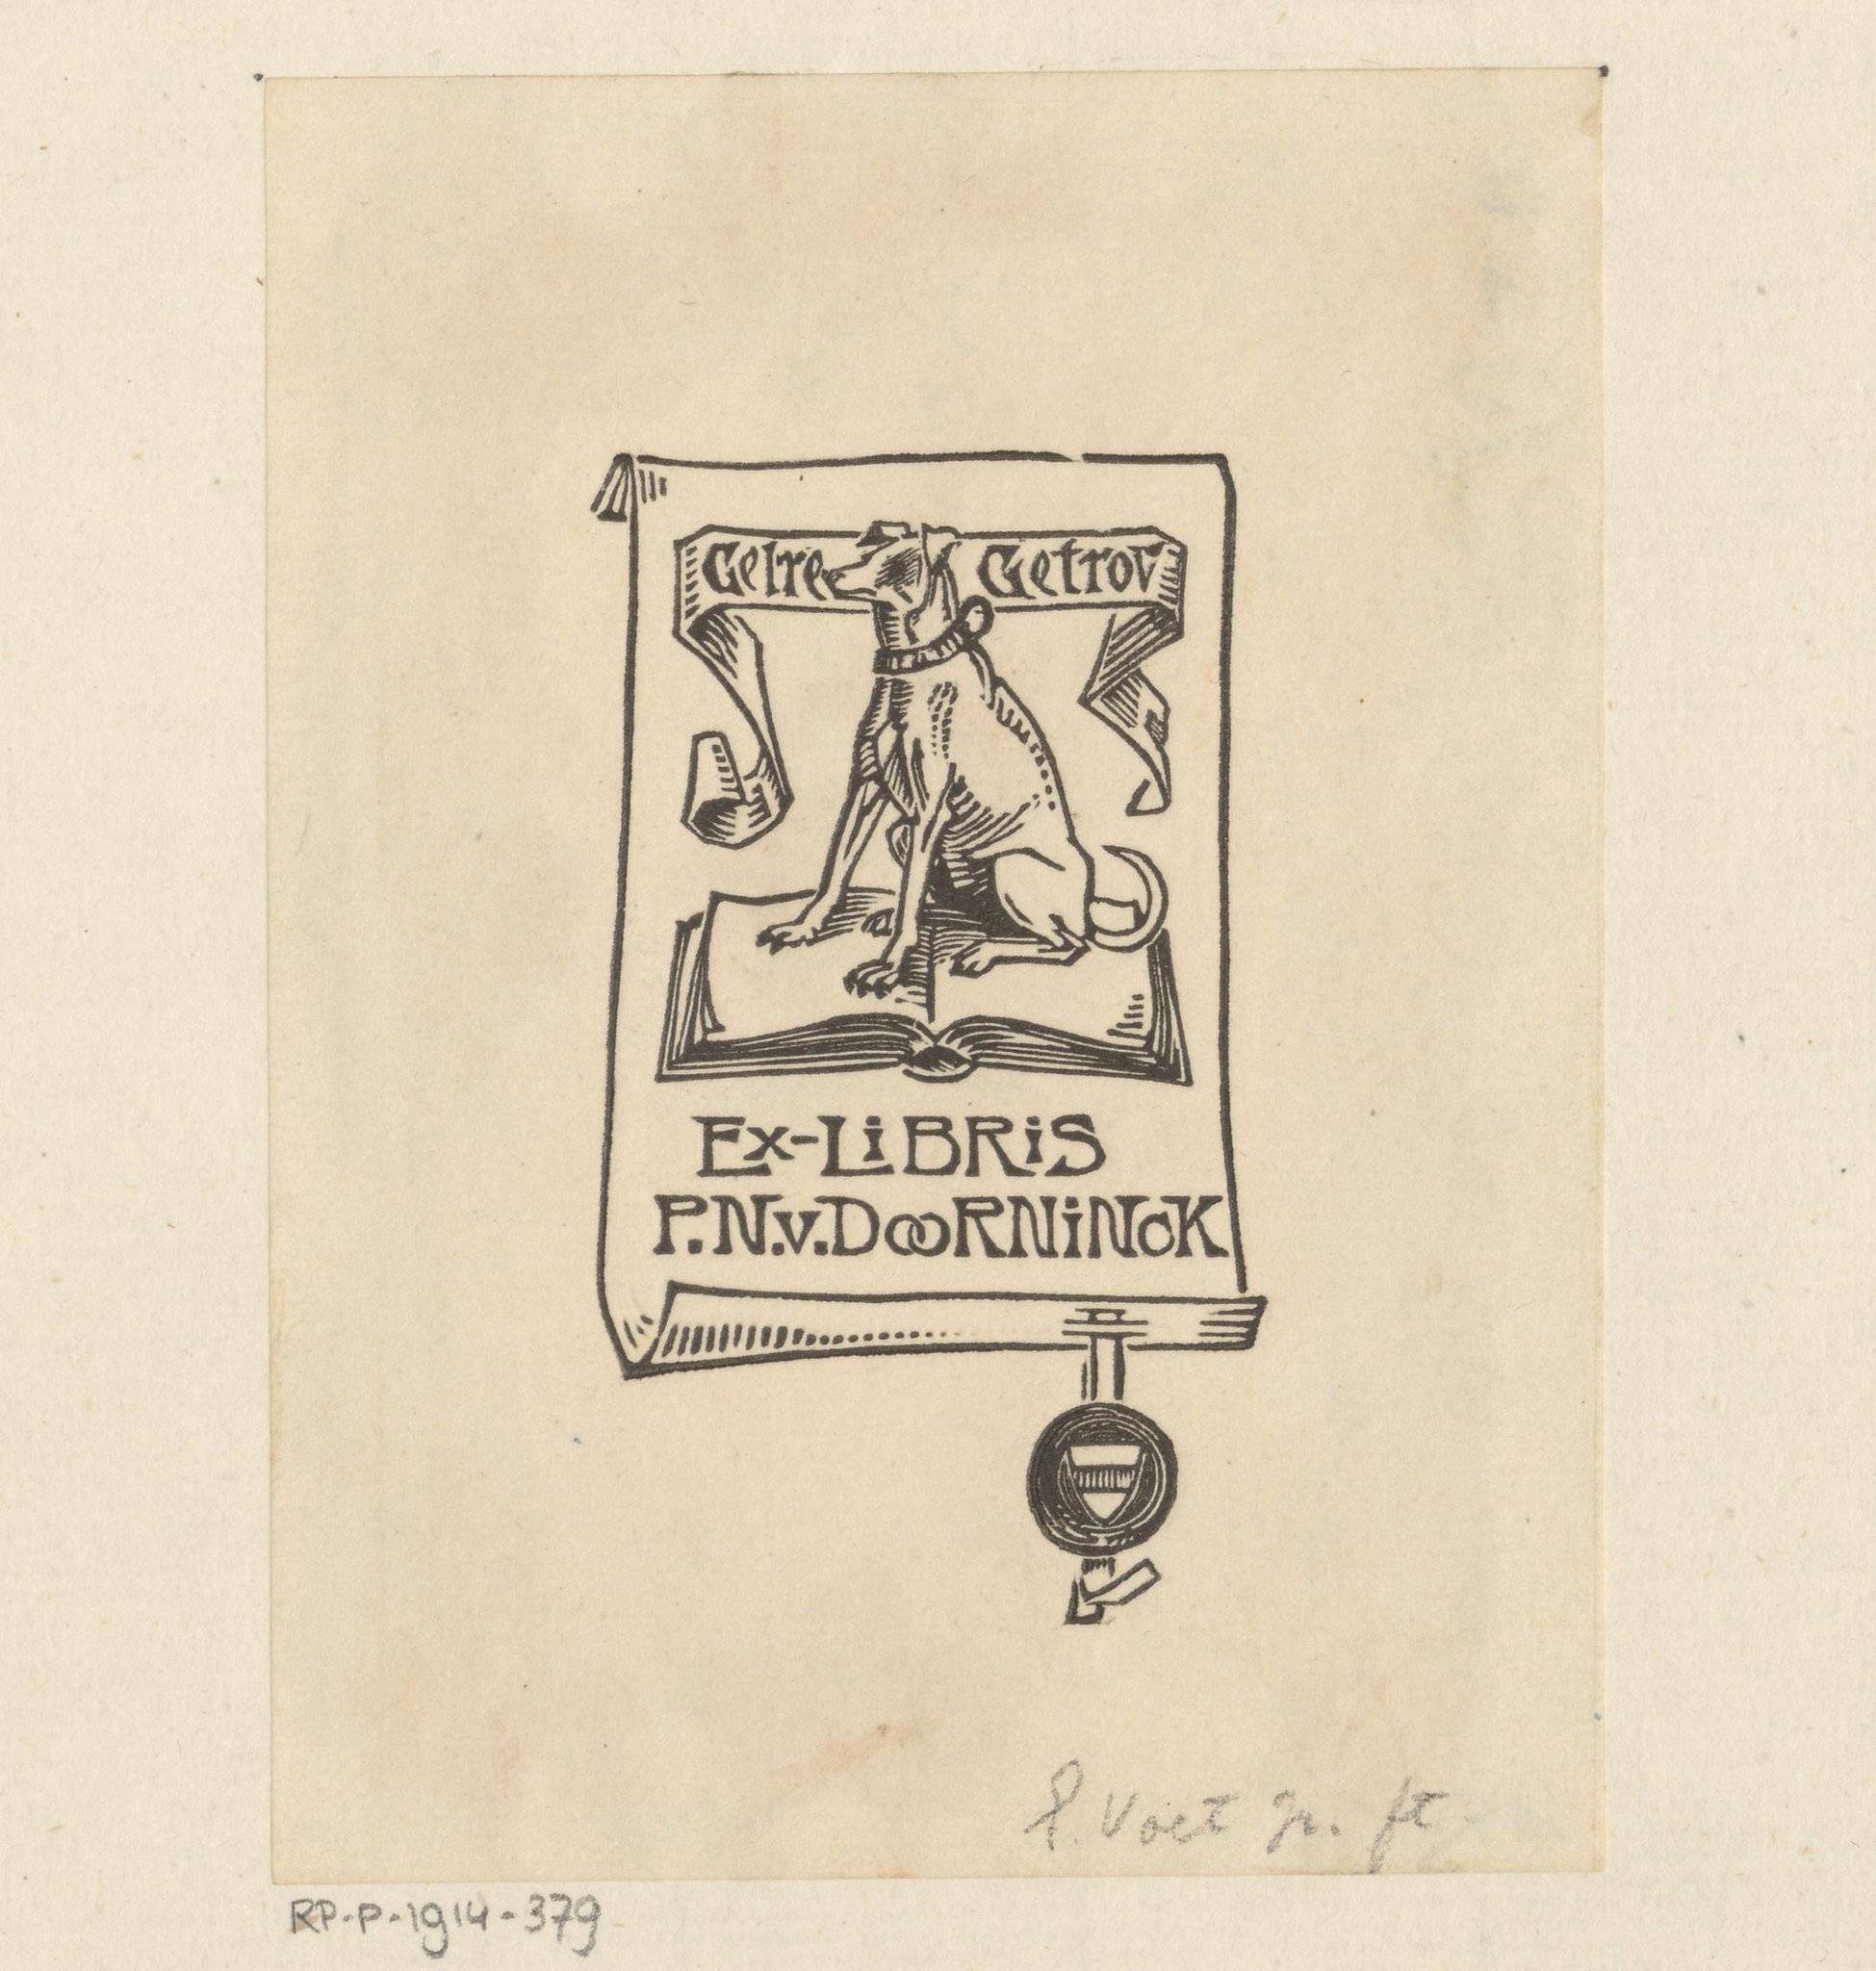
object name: bookplate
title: Ex libris van Pieter Nicolaas van Doorninck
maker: elias voet jr.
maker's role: jeweler, print maker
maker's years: 1868-1940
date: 1878-1914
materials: paper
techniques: engraving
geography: netherlands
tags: utrecht, book, scroll, dog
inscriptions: collector's mark: Lugt 2233, signature: ‘E. Voet Jr. ft’